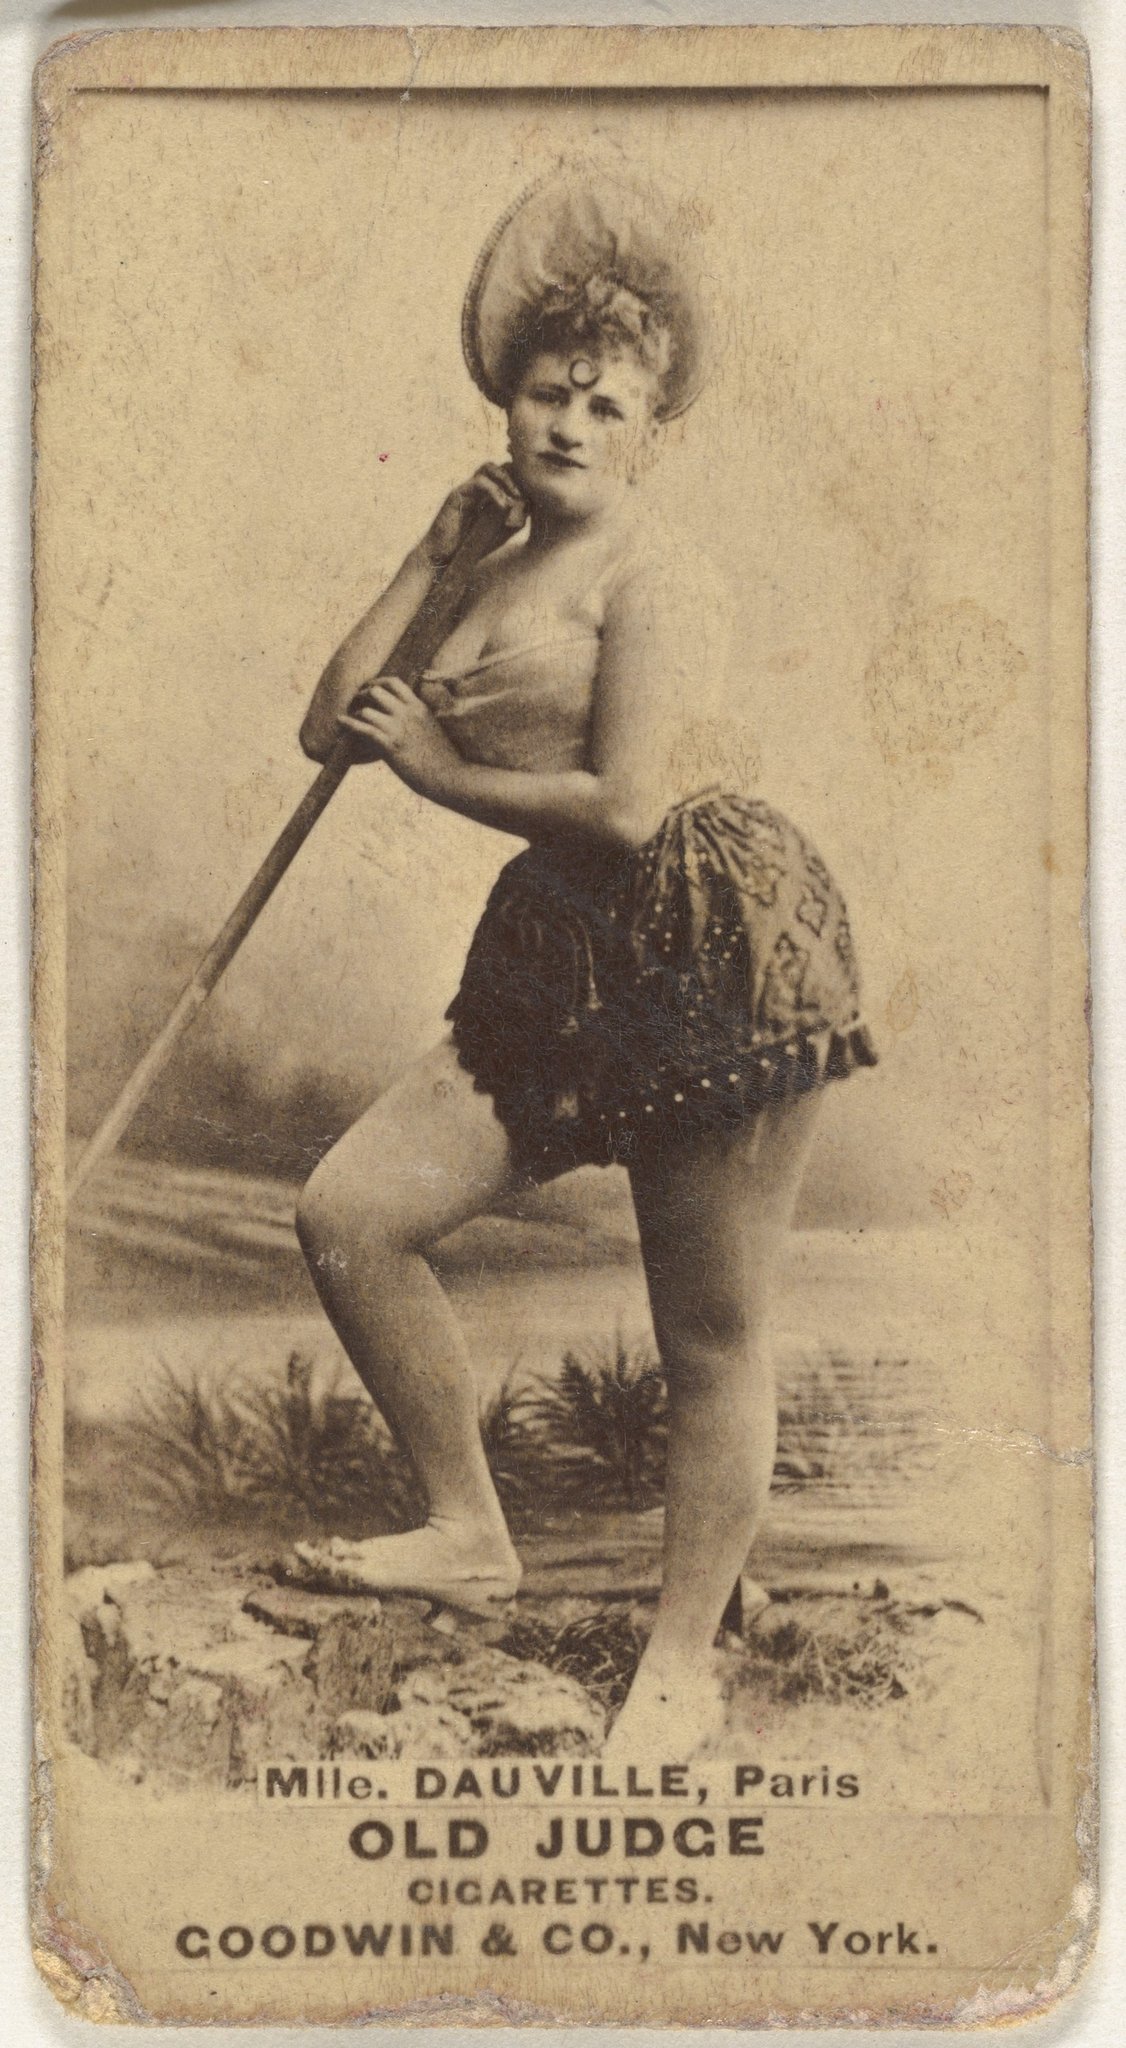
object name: photograph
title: Mlle. Dauville, Paris, from the Actors and Actresses series (N171) for Old Judge Cigarettes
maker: goodwin & company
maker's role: publisher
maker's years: 1850-1950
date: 1886-1890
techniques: albumen silver print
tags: portraits,women,actresses